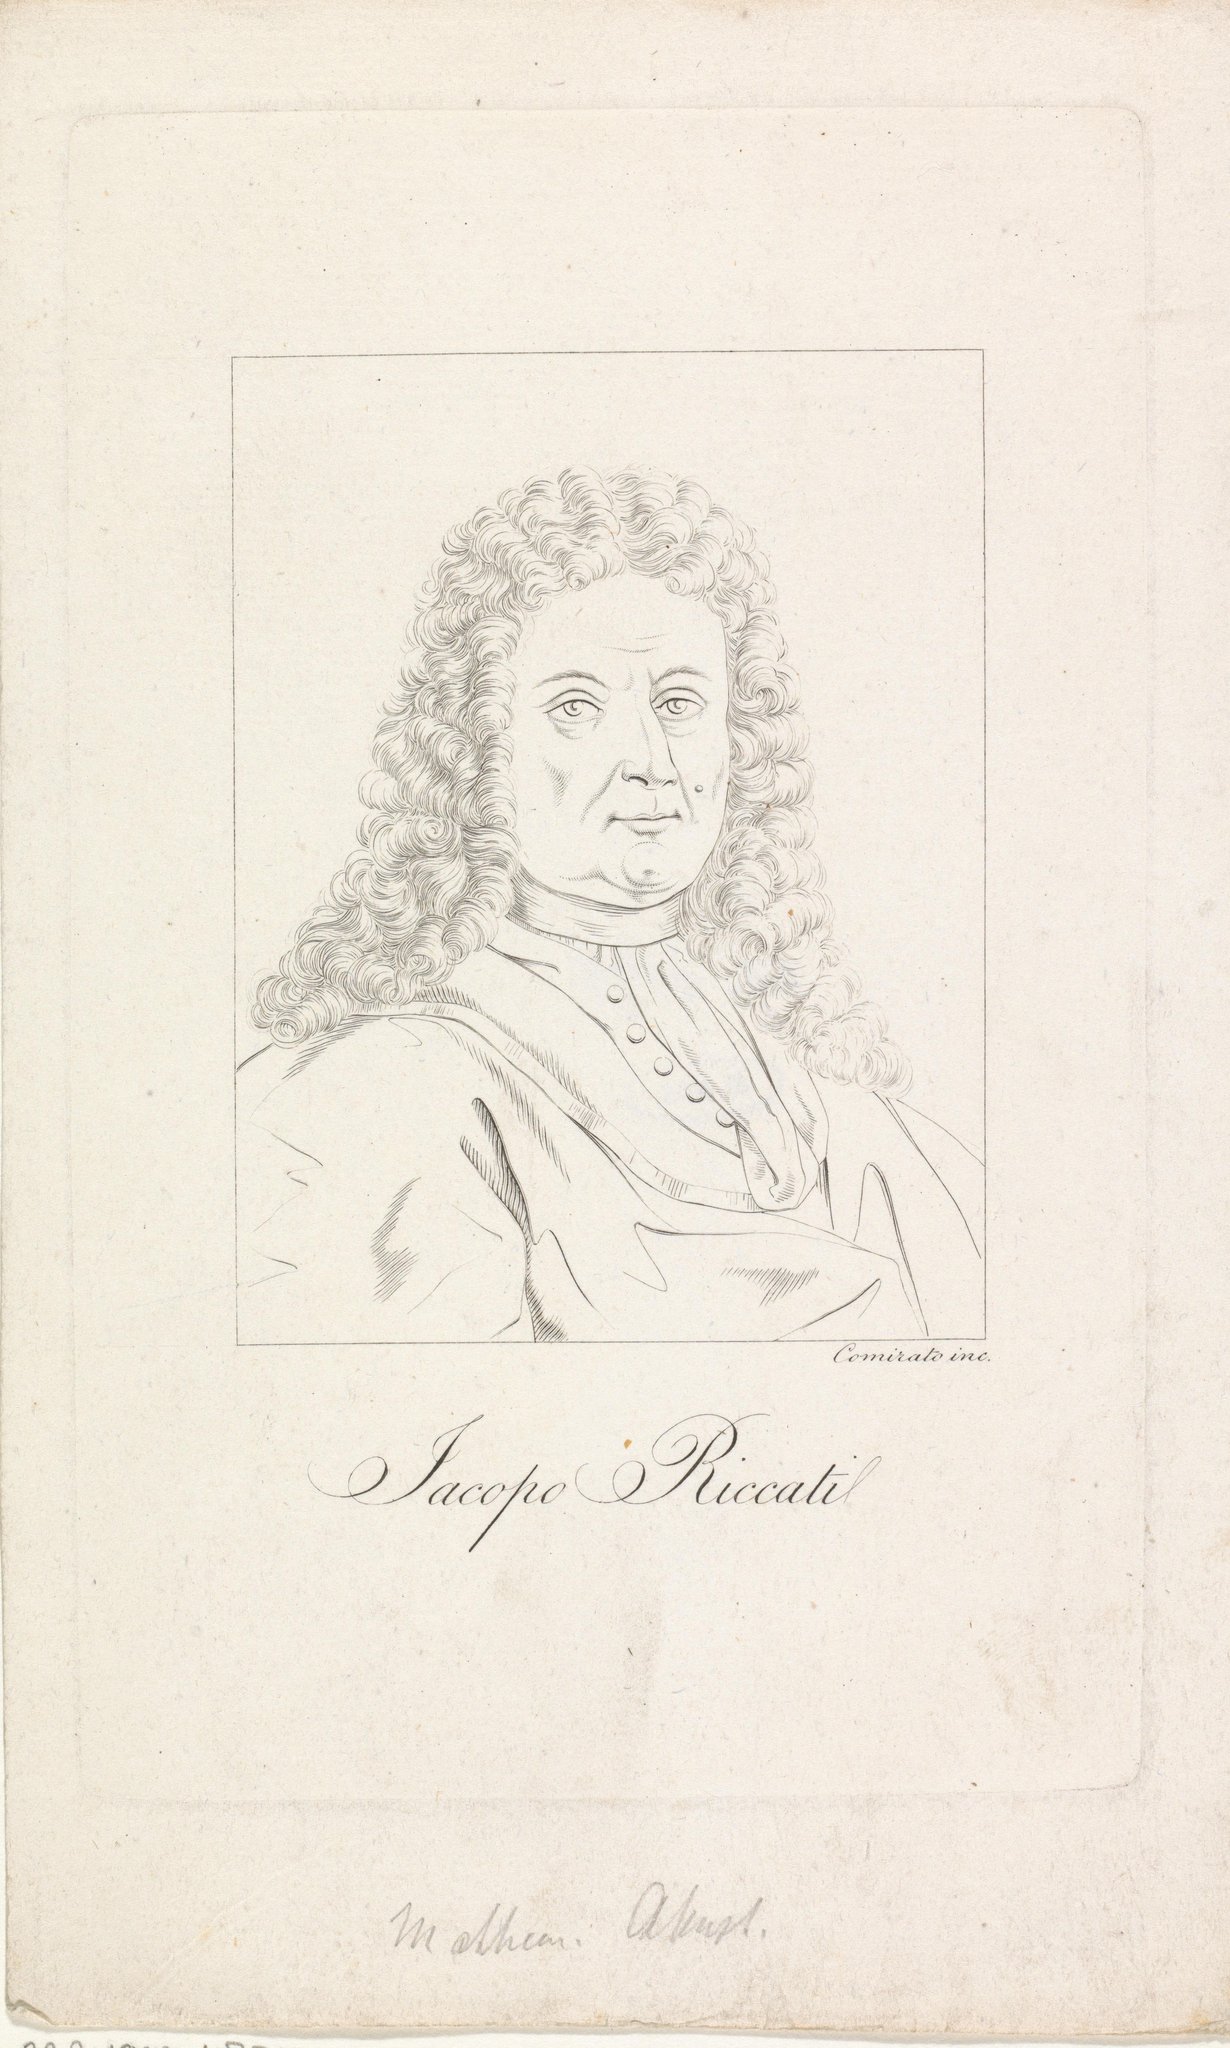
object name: print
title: Portret van wiskundige Jacopo Francesco Riccati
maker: marco comirato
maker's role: print maker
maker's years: 1800-1869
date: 1810-1869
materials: paper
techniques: engraving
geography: italy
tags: venice, historical persons, science and technology (+ portrait of scholar, scientist)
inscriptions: collector's mark: Lugt 2228